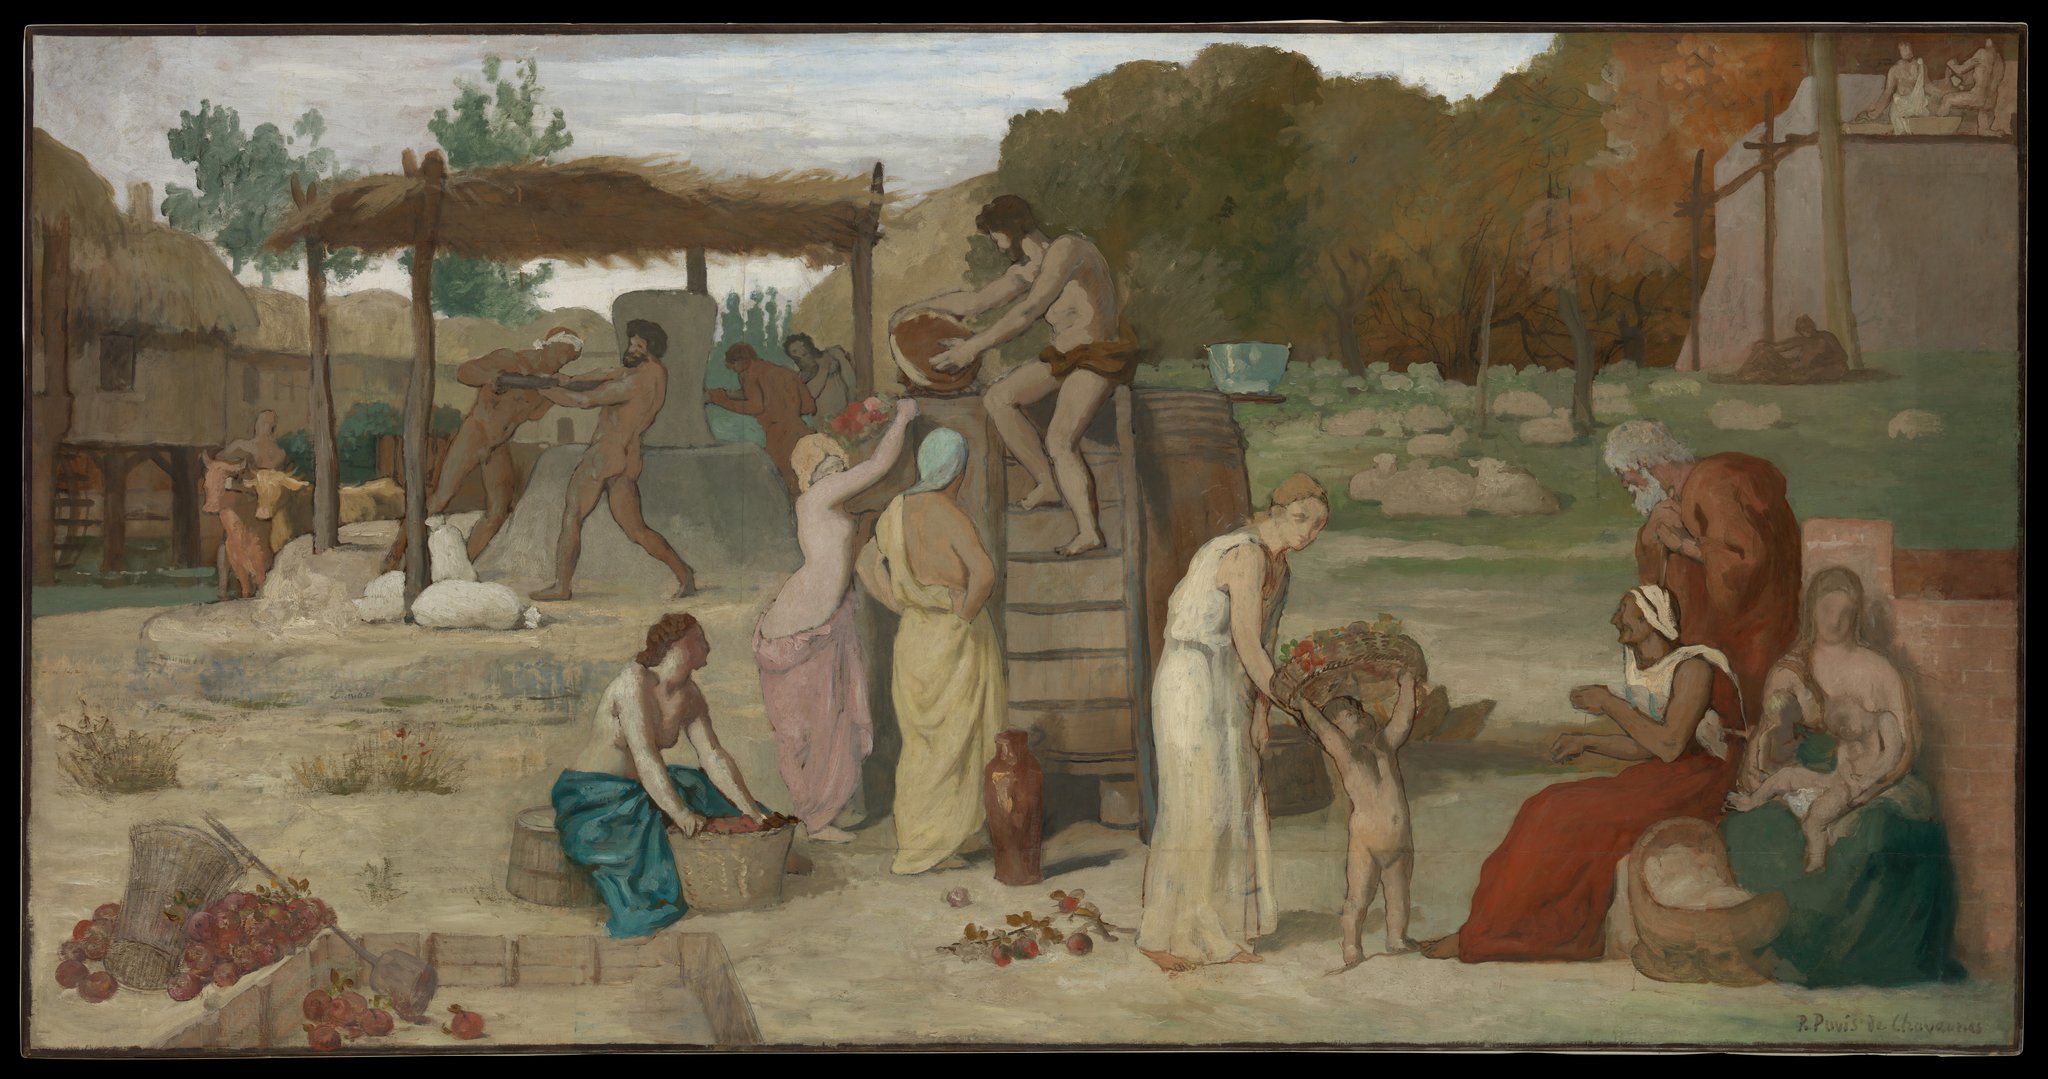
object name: drawing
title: Cider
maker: pierre puvis de chavannes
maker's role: artist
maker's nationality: french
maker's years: 1824-1898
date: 1864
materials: canvas, oil, paper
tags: apples,children,men,male nudes,women,working